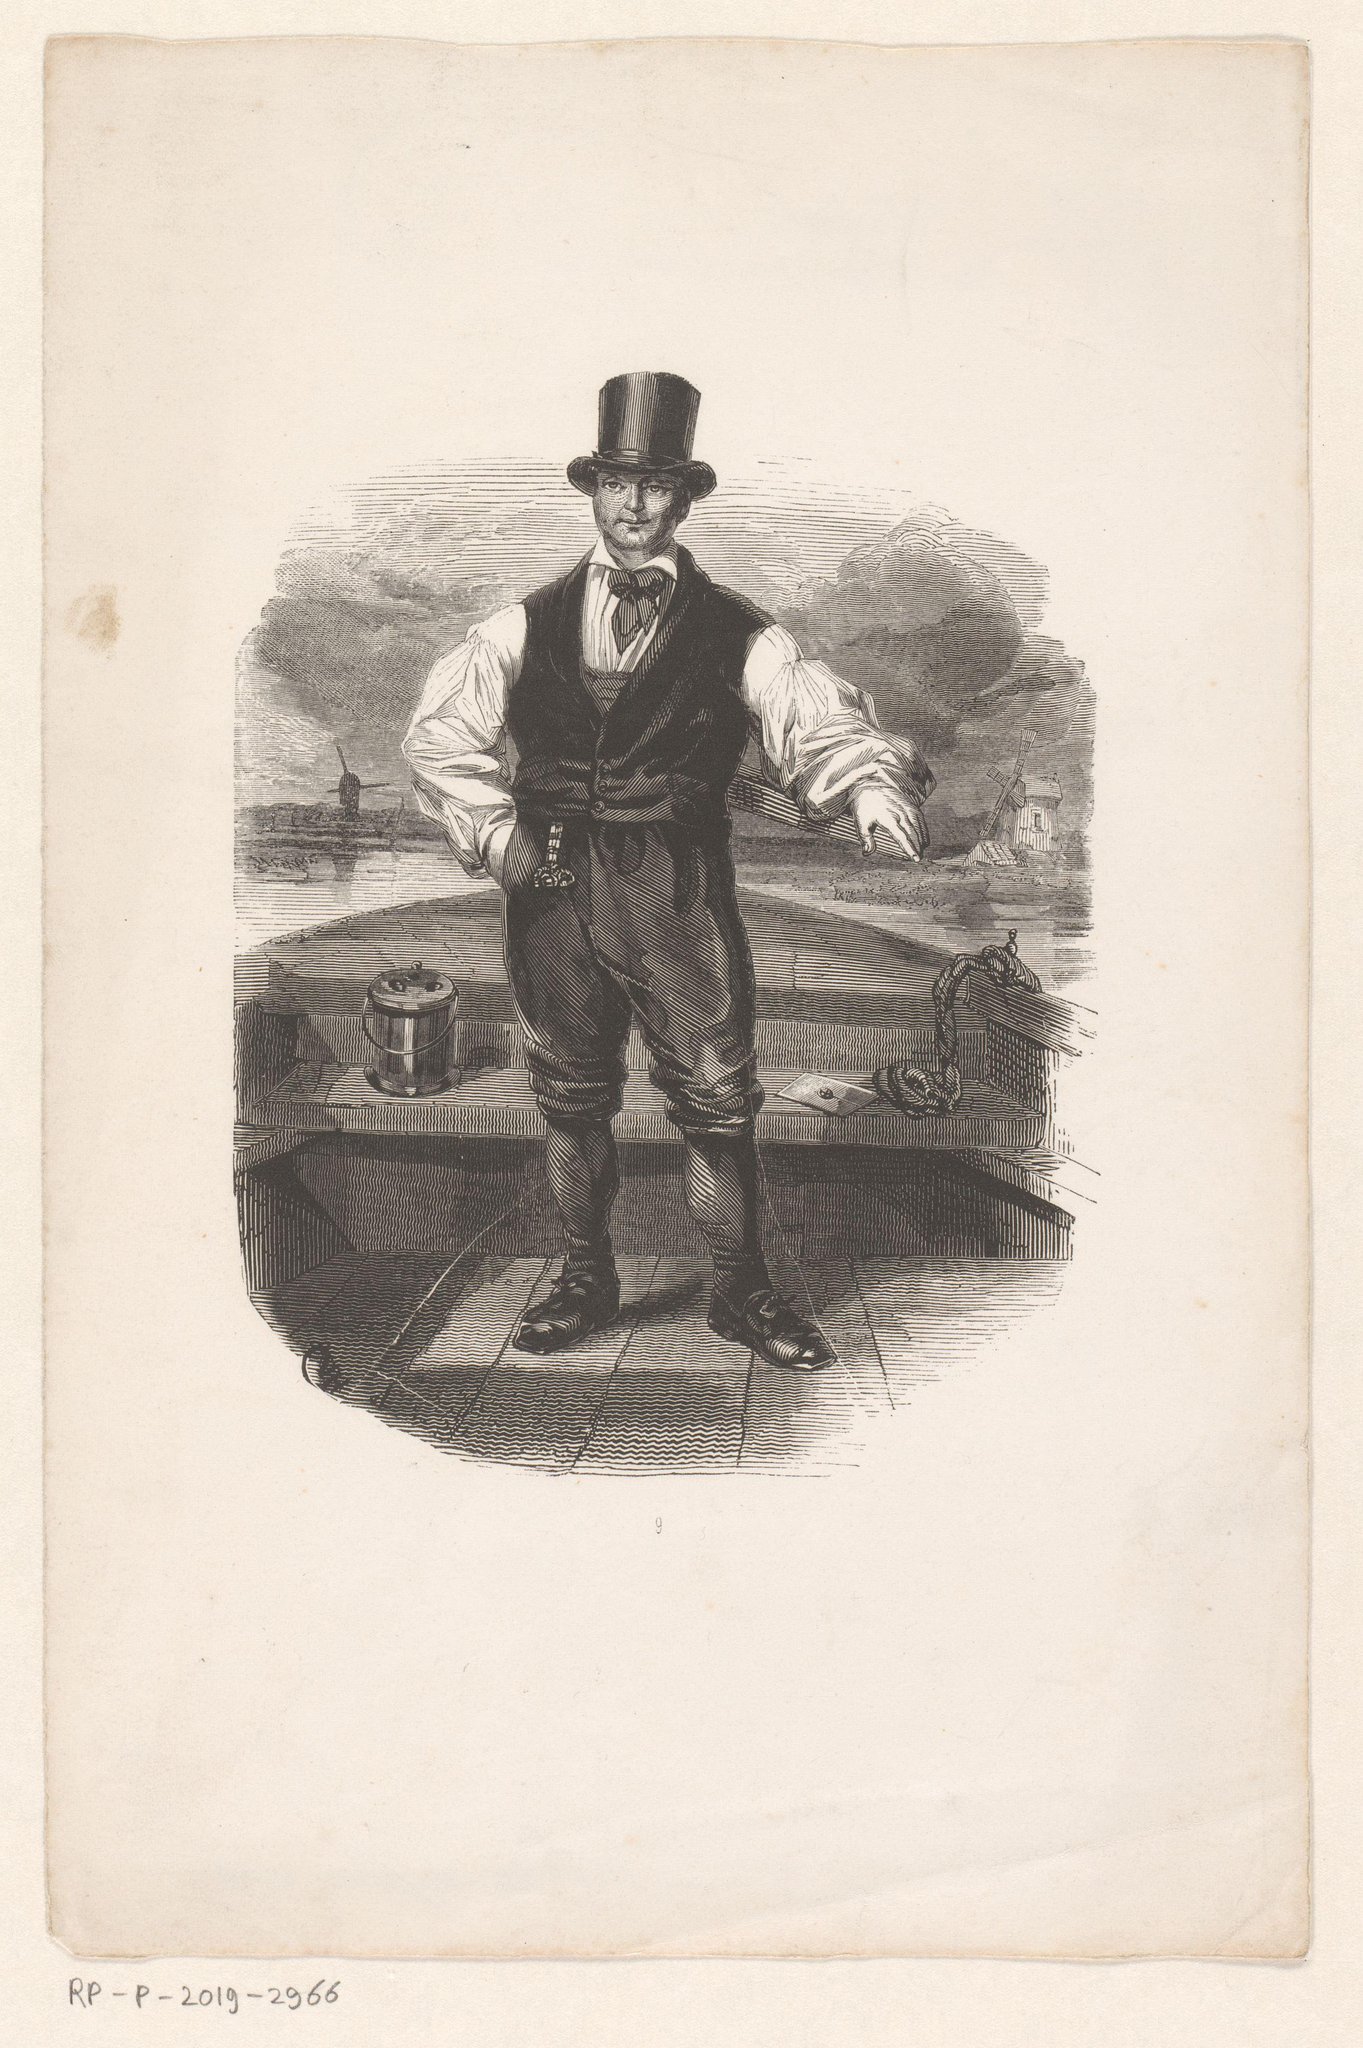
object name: print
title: Veerschipper, 1840-1841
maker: henry brown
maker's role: print maker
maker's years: 1816-1870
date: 1841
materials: paper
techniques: engraving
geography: the hague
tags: crew ~ ship, professional clothes, standing figure, at the helm (manoeuvering), head-gear: hat, ferry, traffic on the water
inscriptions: collector's mark: Lugt 2228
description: Gebruikt als illustratie in: De Nederlanden : karakterschetsen, kleederdrachten, houding en voorkomen van verschillende standen : tekst van de meest geachte schrijvers : met gravuren van Henry Brown naar teekeningen van de voornaamste Nederlandsche kunstenaars. Den Haag: Nederlandsche Maatschappij van Schoone Kunsten, 1841. Zie ook BI-B-FM-124-0.